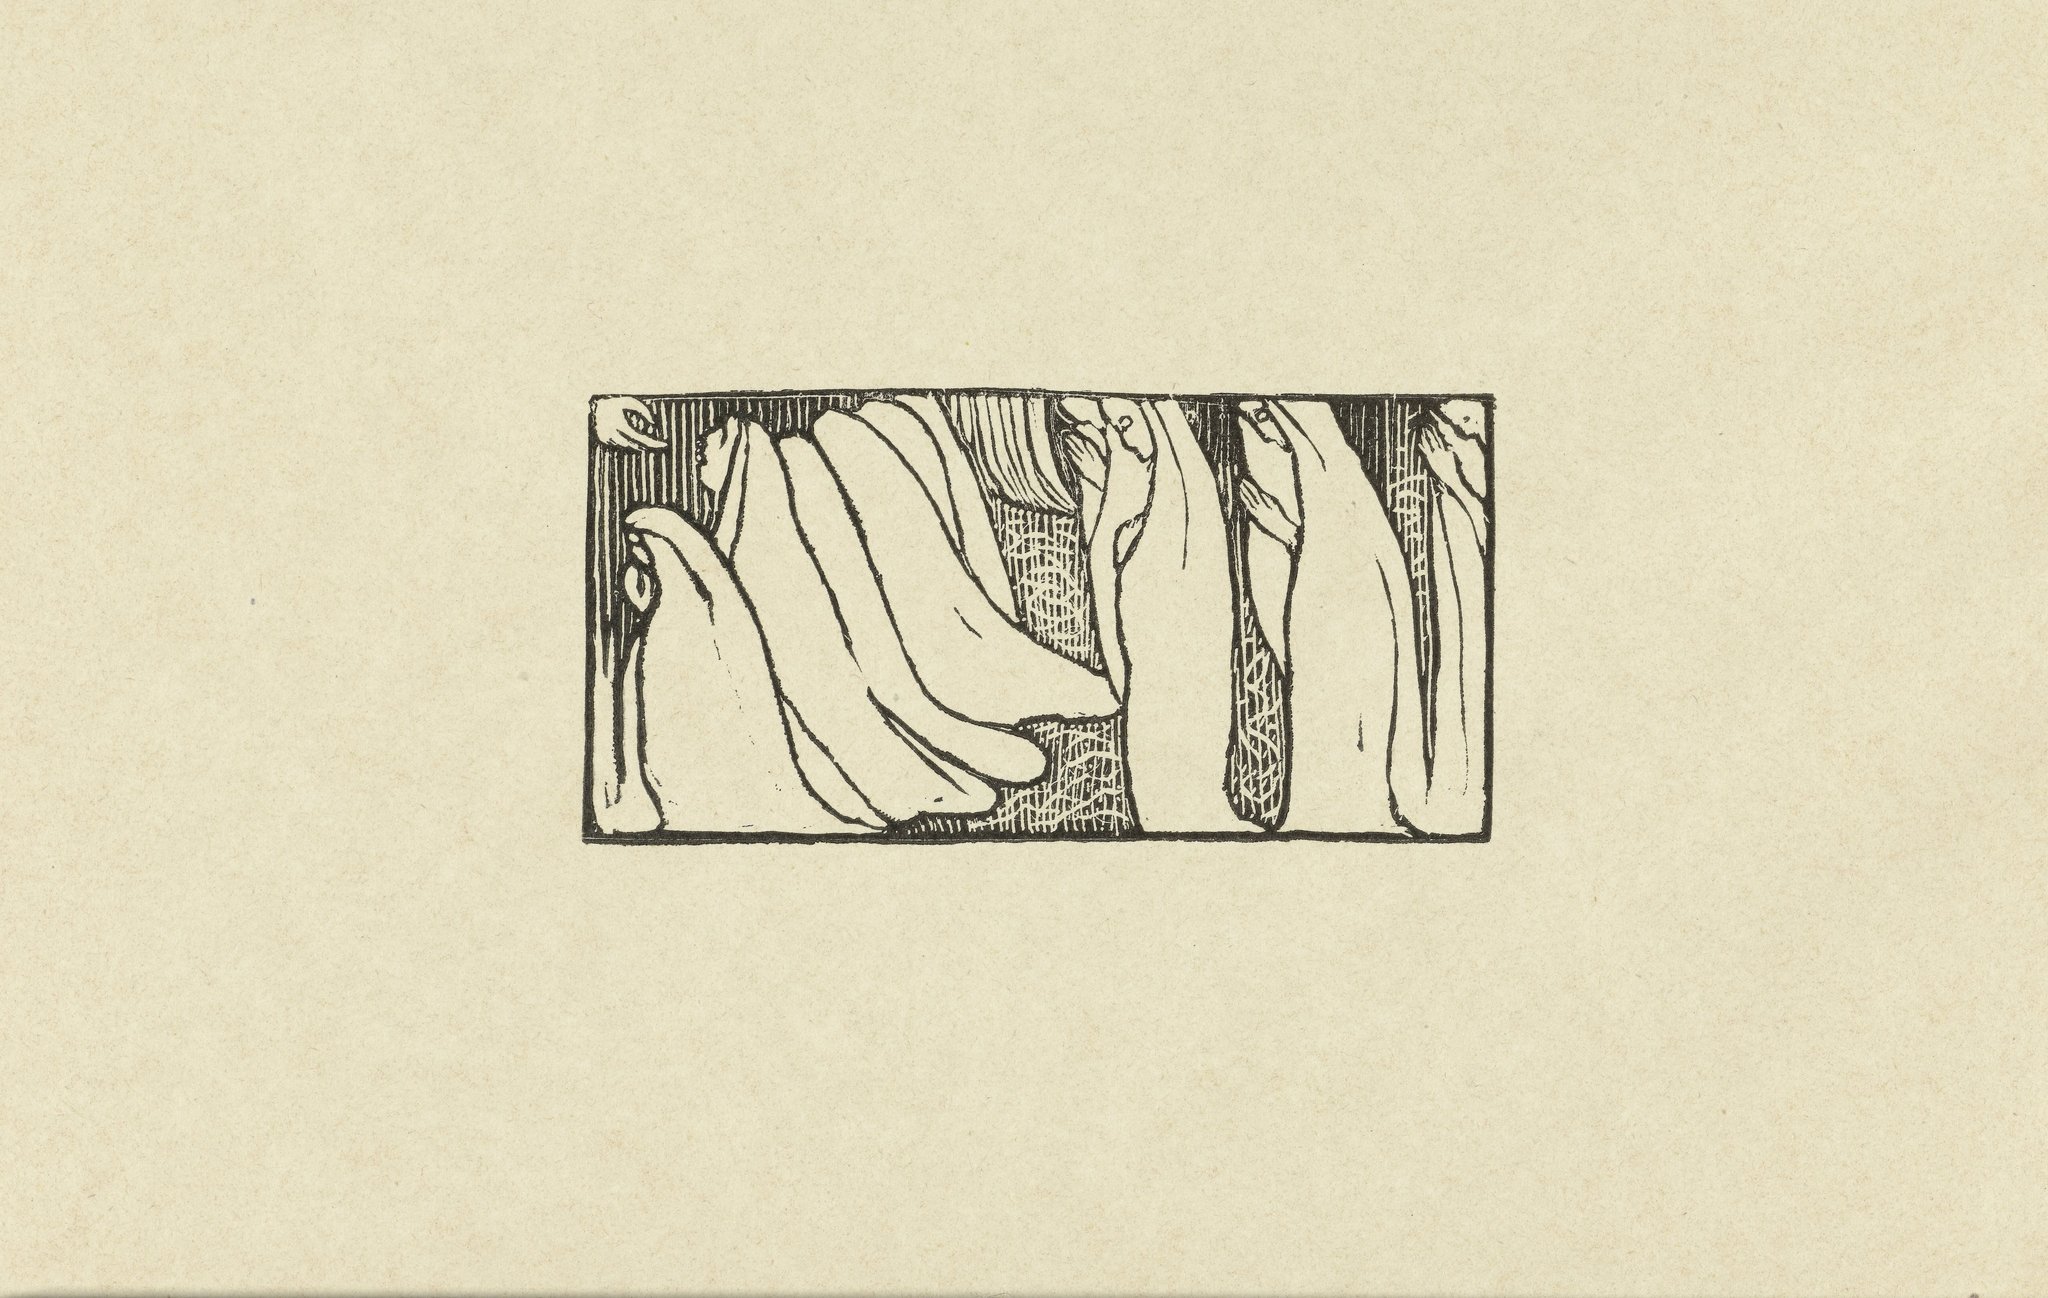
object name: print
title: Illustratie bij gedicht uit dichtbundel Sagesse van Paul Verlaine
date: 1807-1895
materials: paper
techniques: woodcut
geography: france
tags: nun(s), hands folded with fingers knit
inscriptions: collector's mark: Lugt 2760, collector's mark: Lugt 2228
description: De dichtbundel Sagesse (Wijsheid) van Paul Verlaine bevat religieuze gedichten. Op dit blad zijn twee illustraties bij gedichten uit de bundel gedrukt (vergelijk RP-P-1967-1106). Verschenen in album met tien originele prenten als supplement bij tijdschrift: L'Epreuve, juli 1895, prent nr. 4.